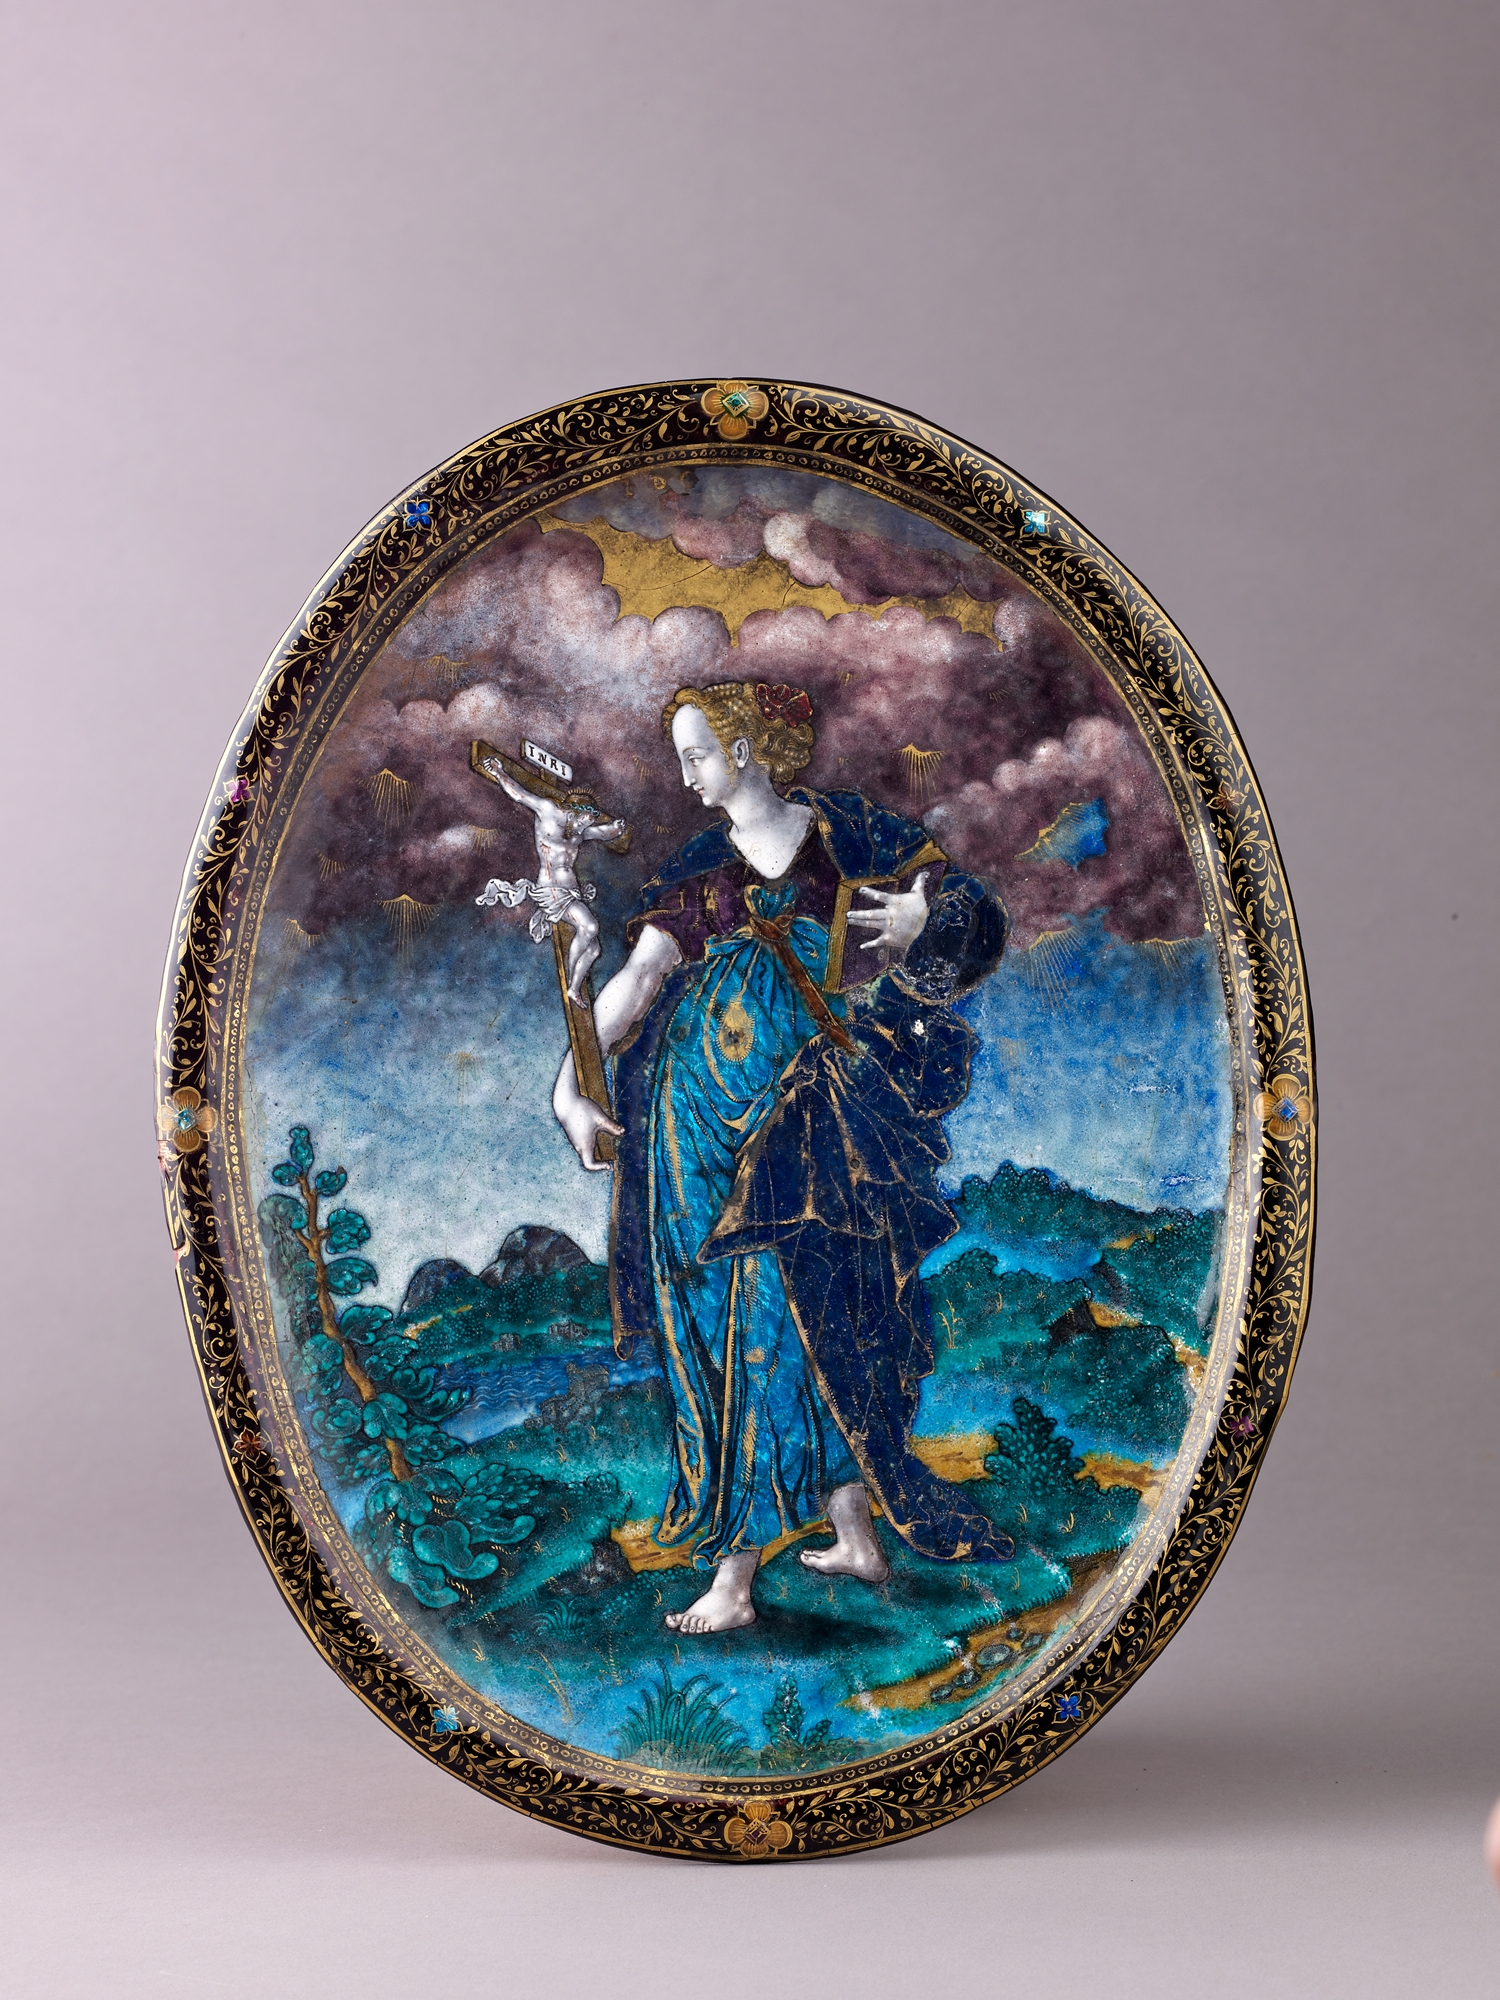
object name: plaque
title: Faith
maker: master idc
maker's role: artist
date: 1567-1600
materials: copper, enamel, gilt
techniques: painting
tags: women,crucifixion